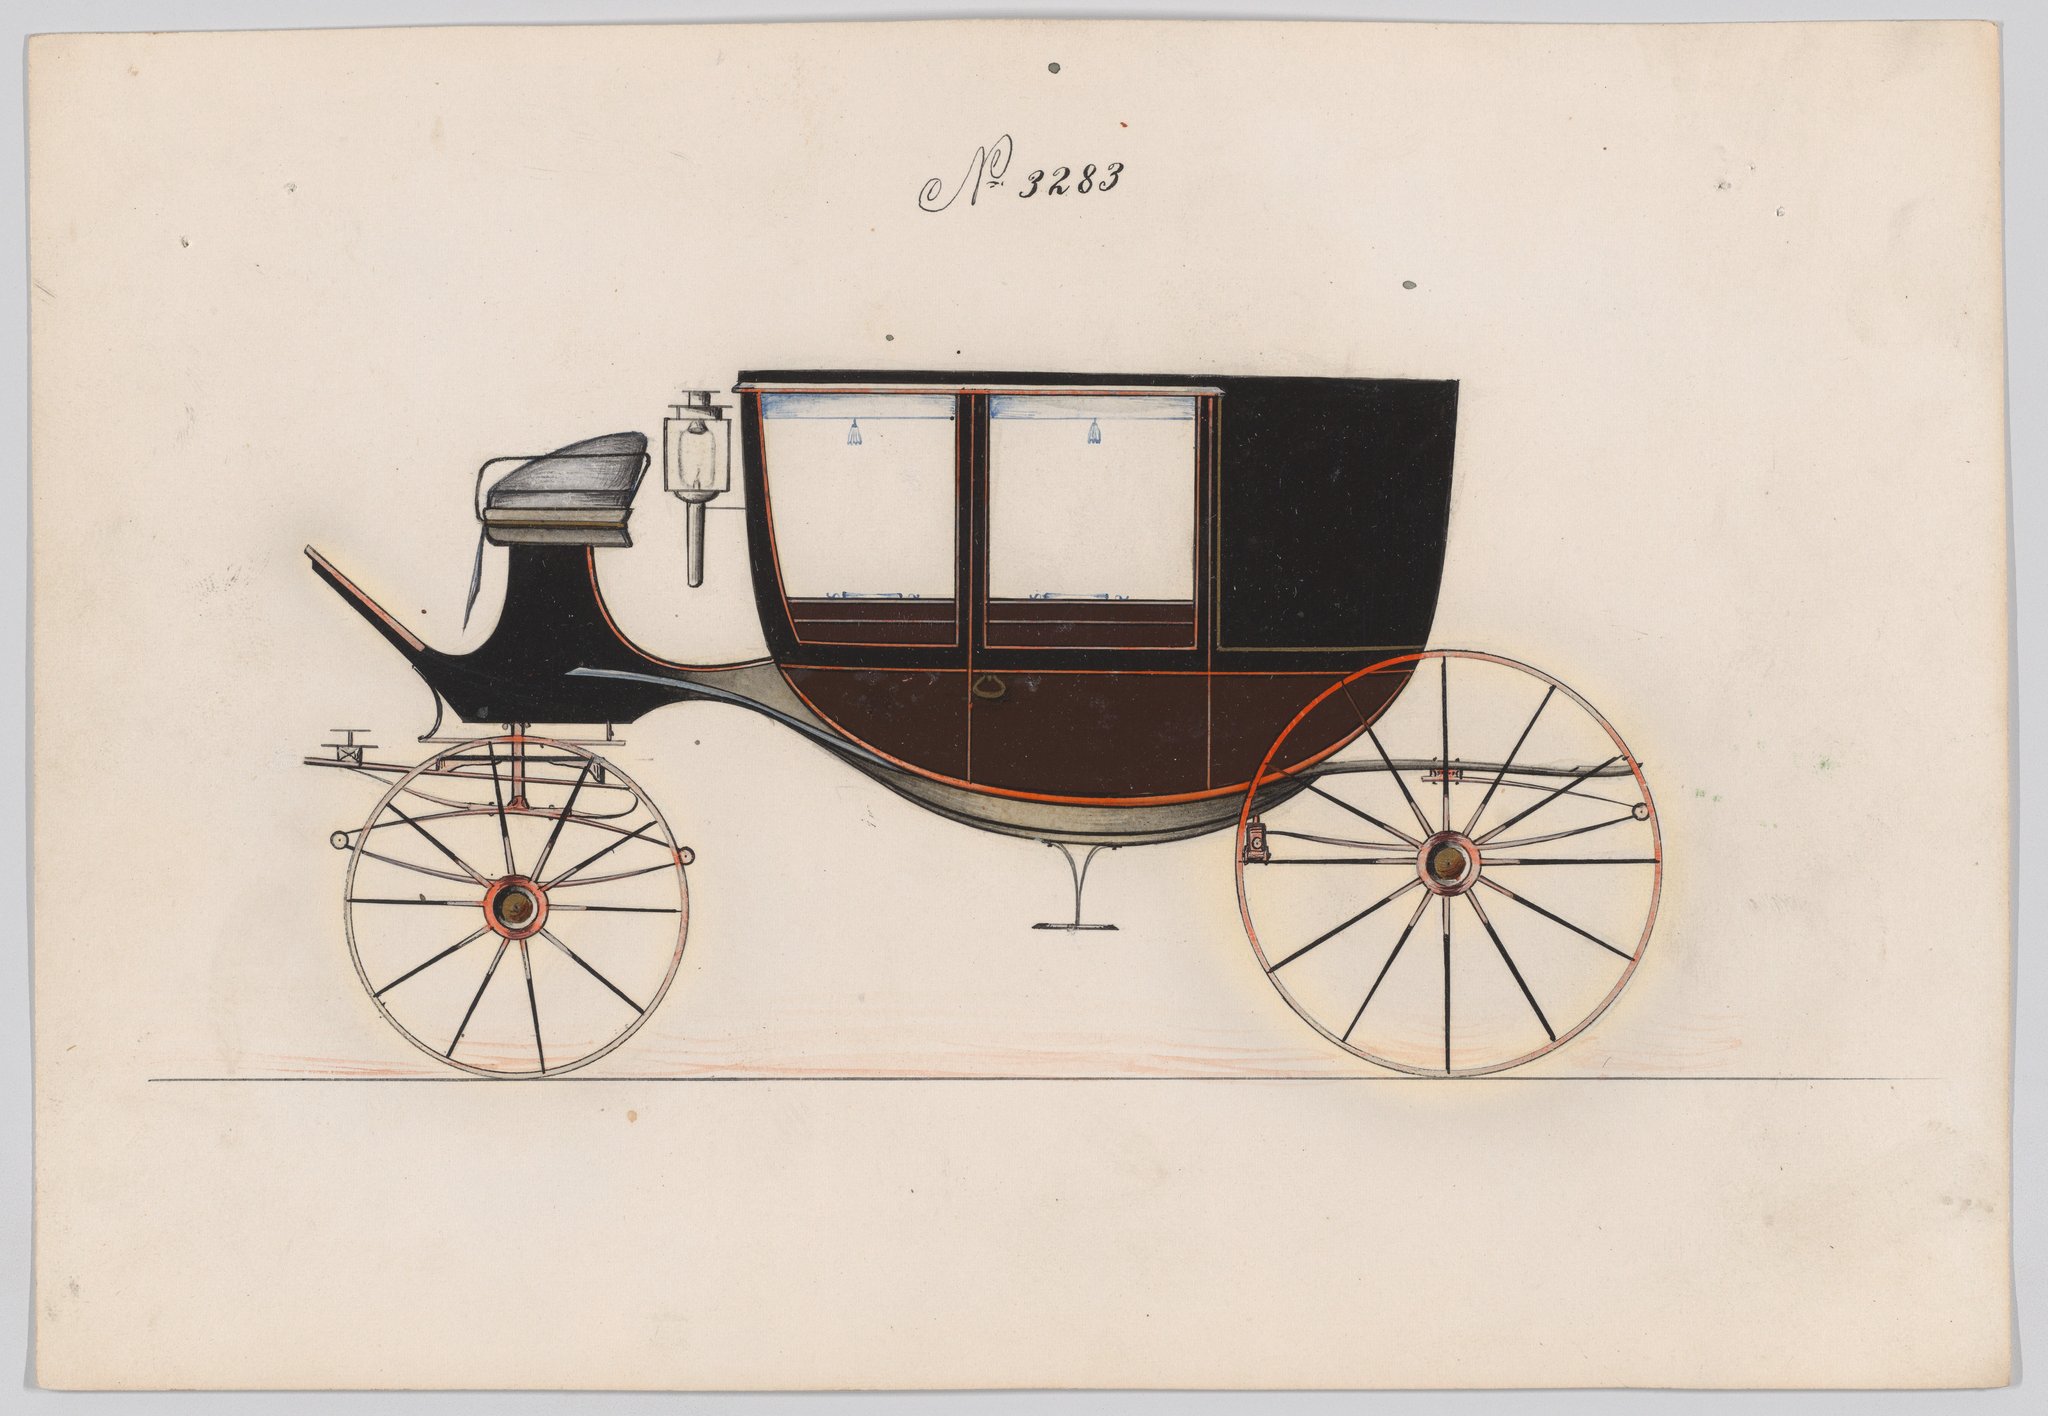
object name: drawing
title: Coach #3283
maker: brewster & co.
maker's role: manufacturer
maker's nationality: american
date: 1876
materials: gouache, gum arabic, ink, watercolor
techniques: pen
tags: carriages